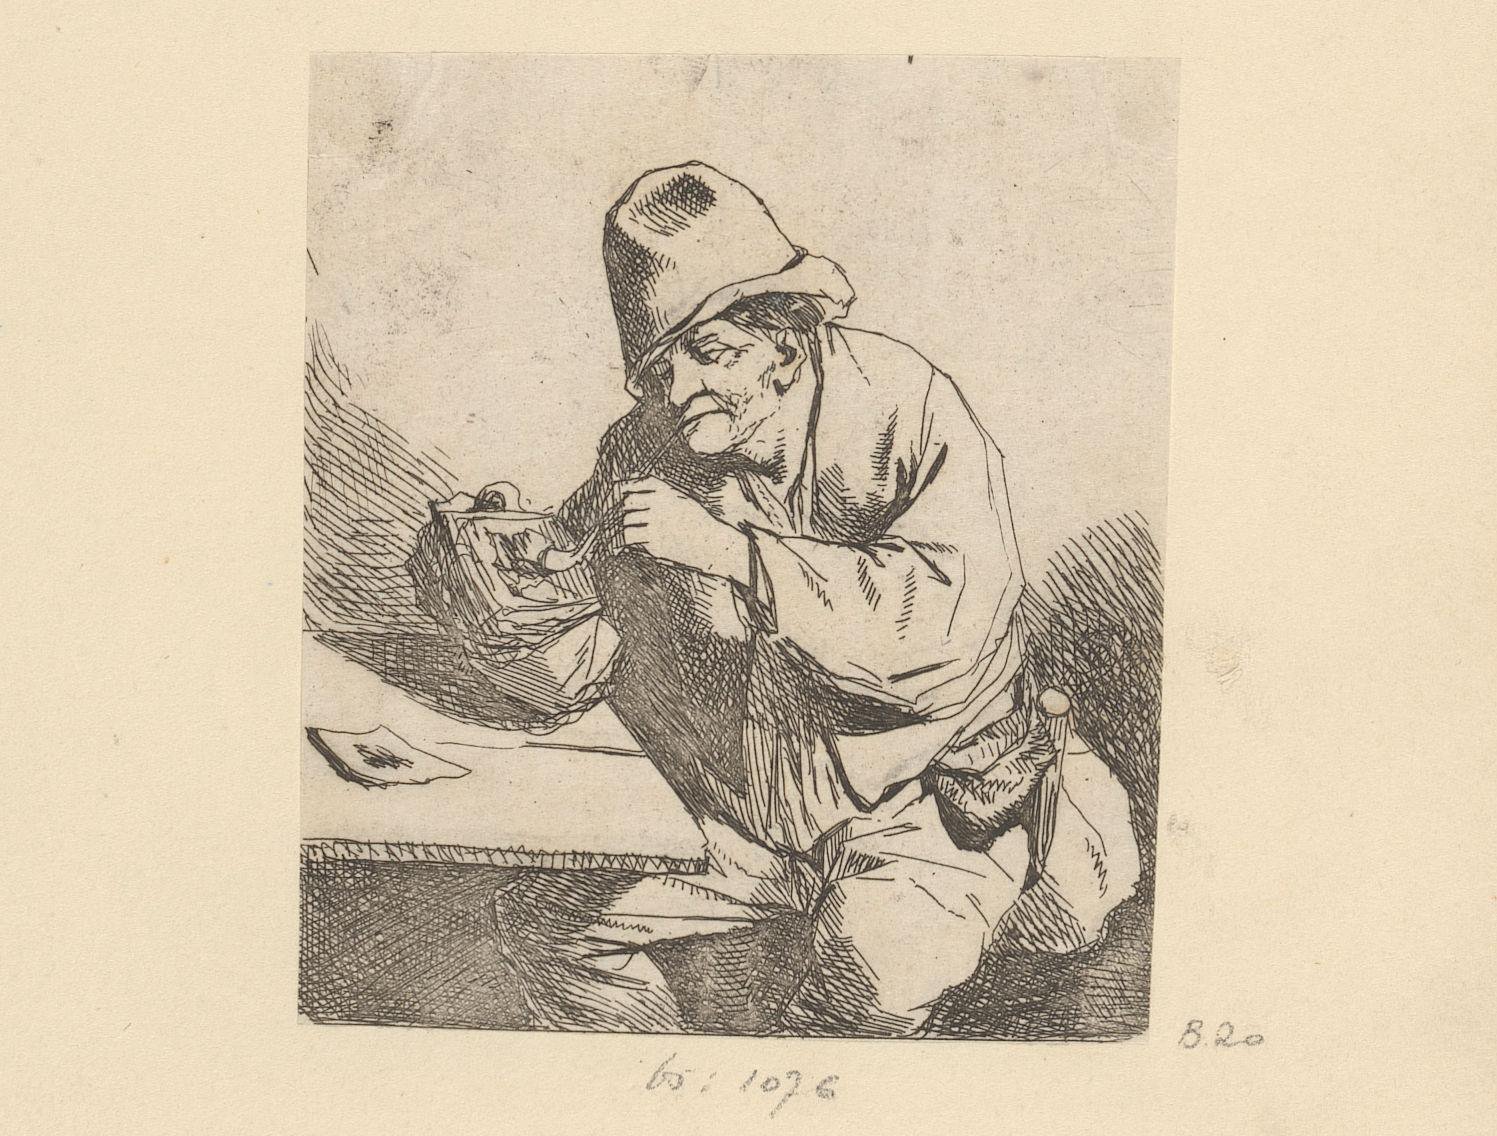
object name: print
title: Man steekt een pijp aan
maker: cornelis pietersz. bega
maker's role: draughtsman, painter, print maker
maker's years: 1631-1664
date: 1641-1664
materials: paper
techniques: etching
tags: pipe ~ tobacco, candle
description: Prent maakt mogelijk deel uit van een serie van 200 prenten. Deze serie is onder de titel 'A Collection of two hundred original etchings' voor het eerst uitgegeven door J.M. Greery in 1816.